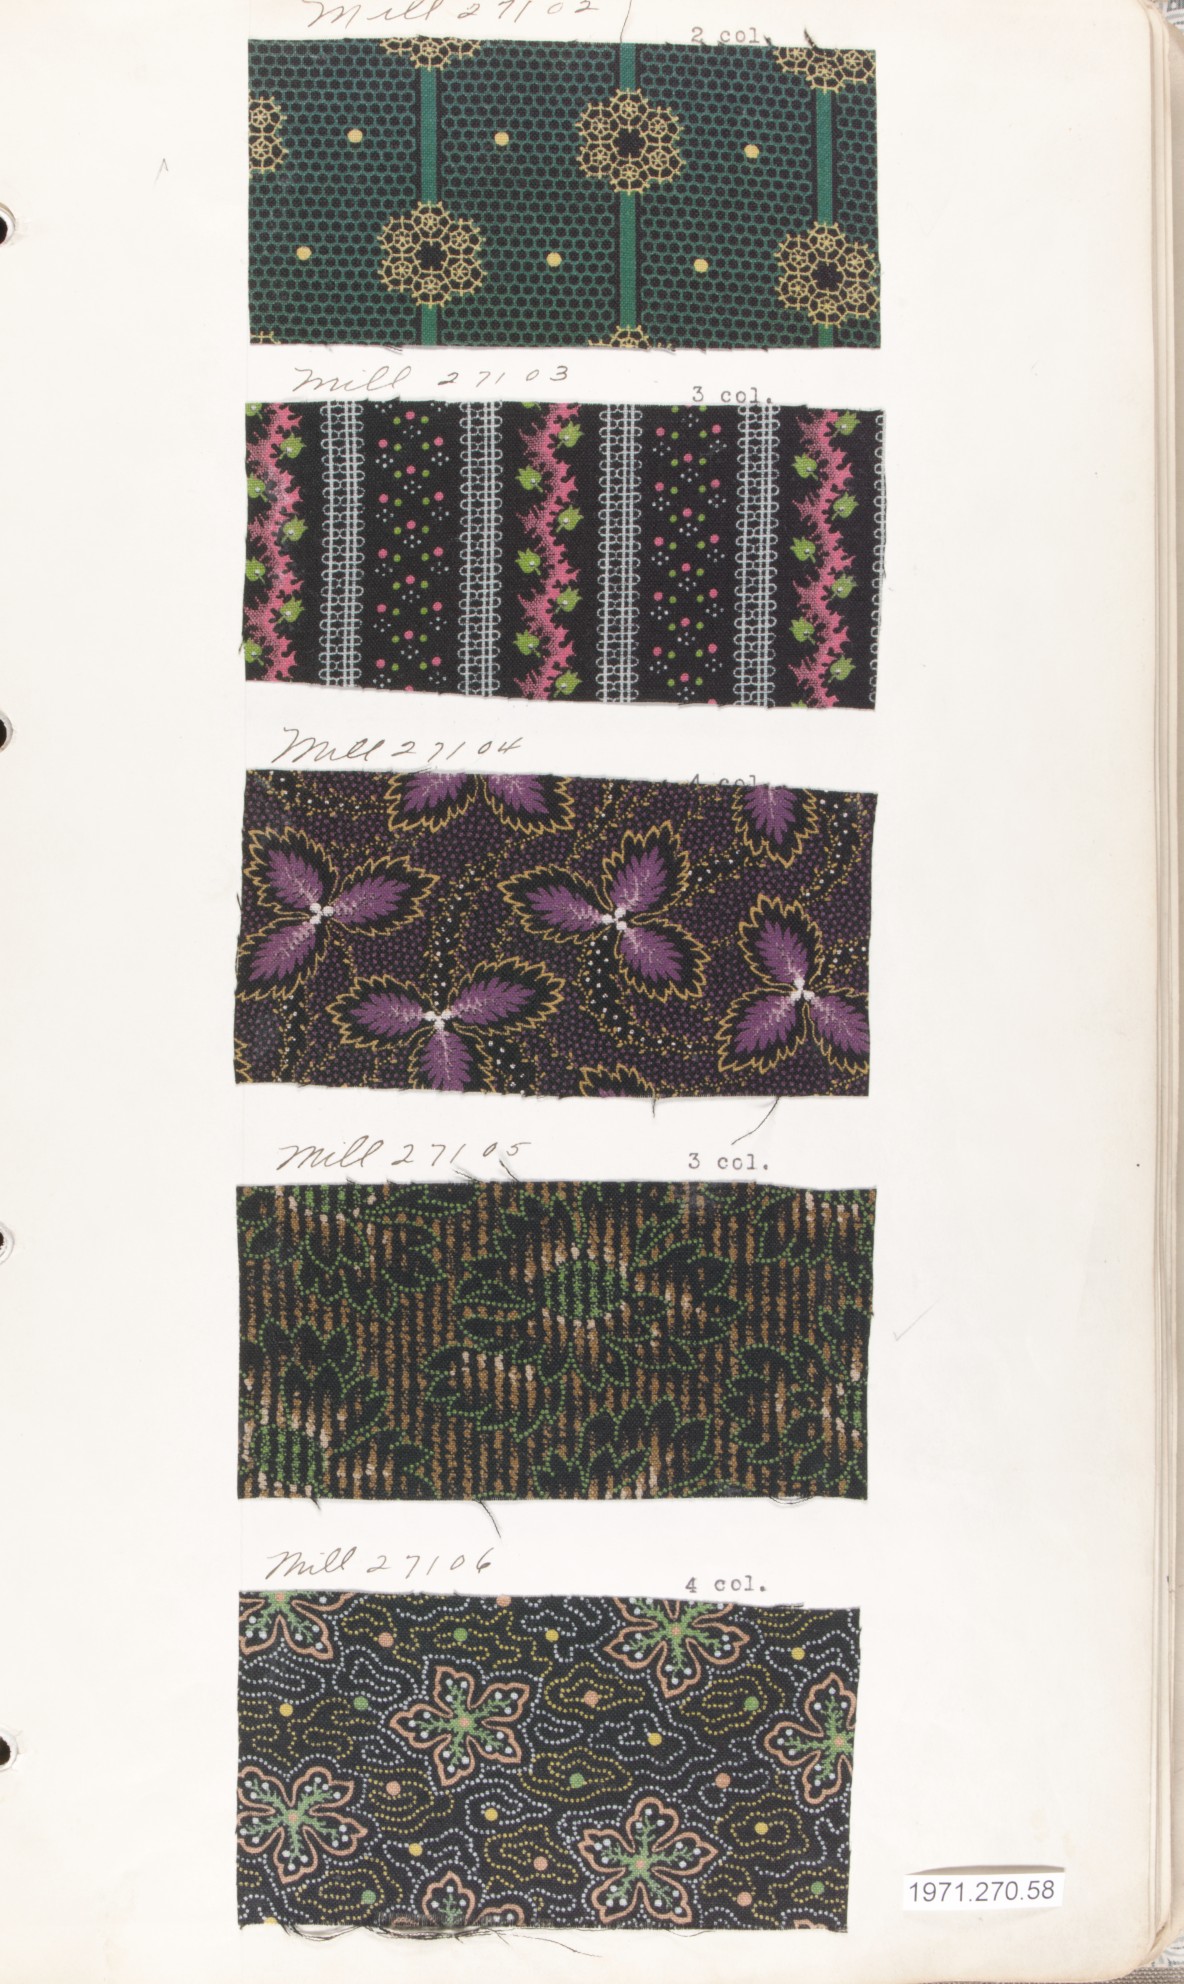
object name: sample book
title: Textile Sample Book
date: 1870-1879